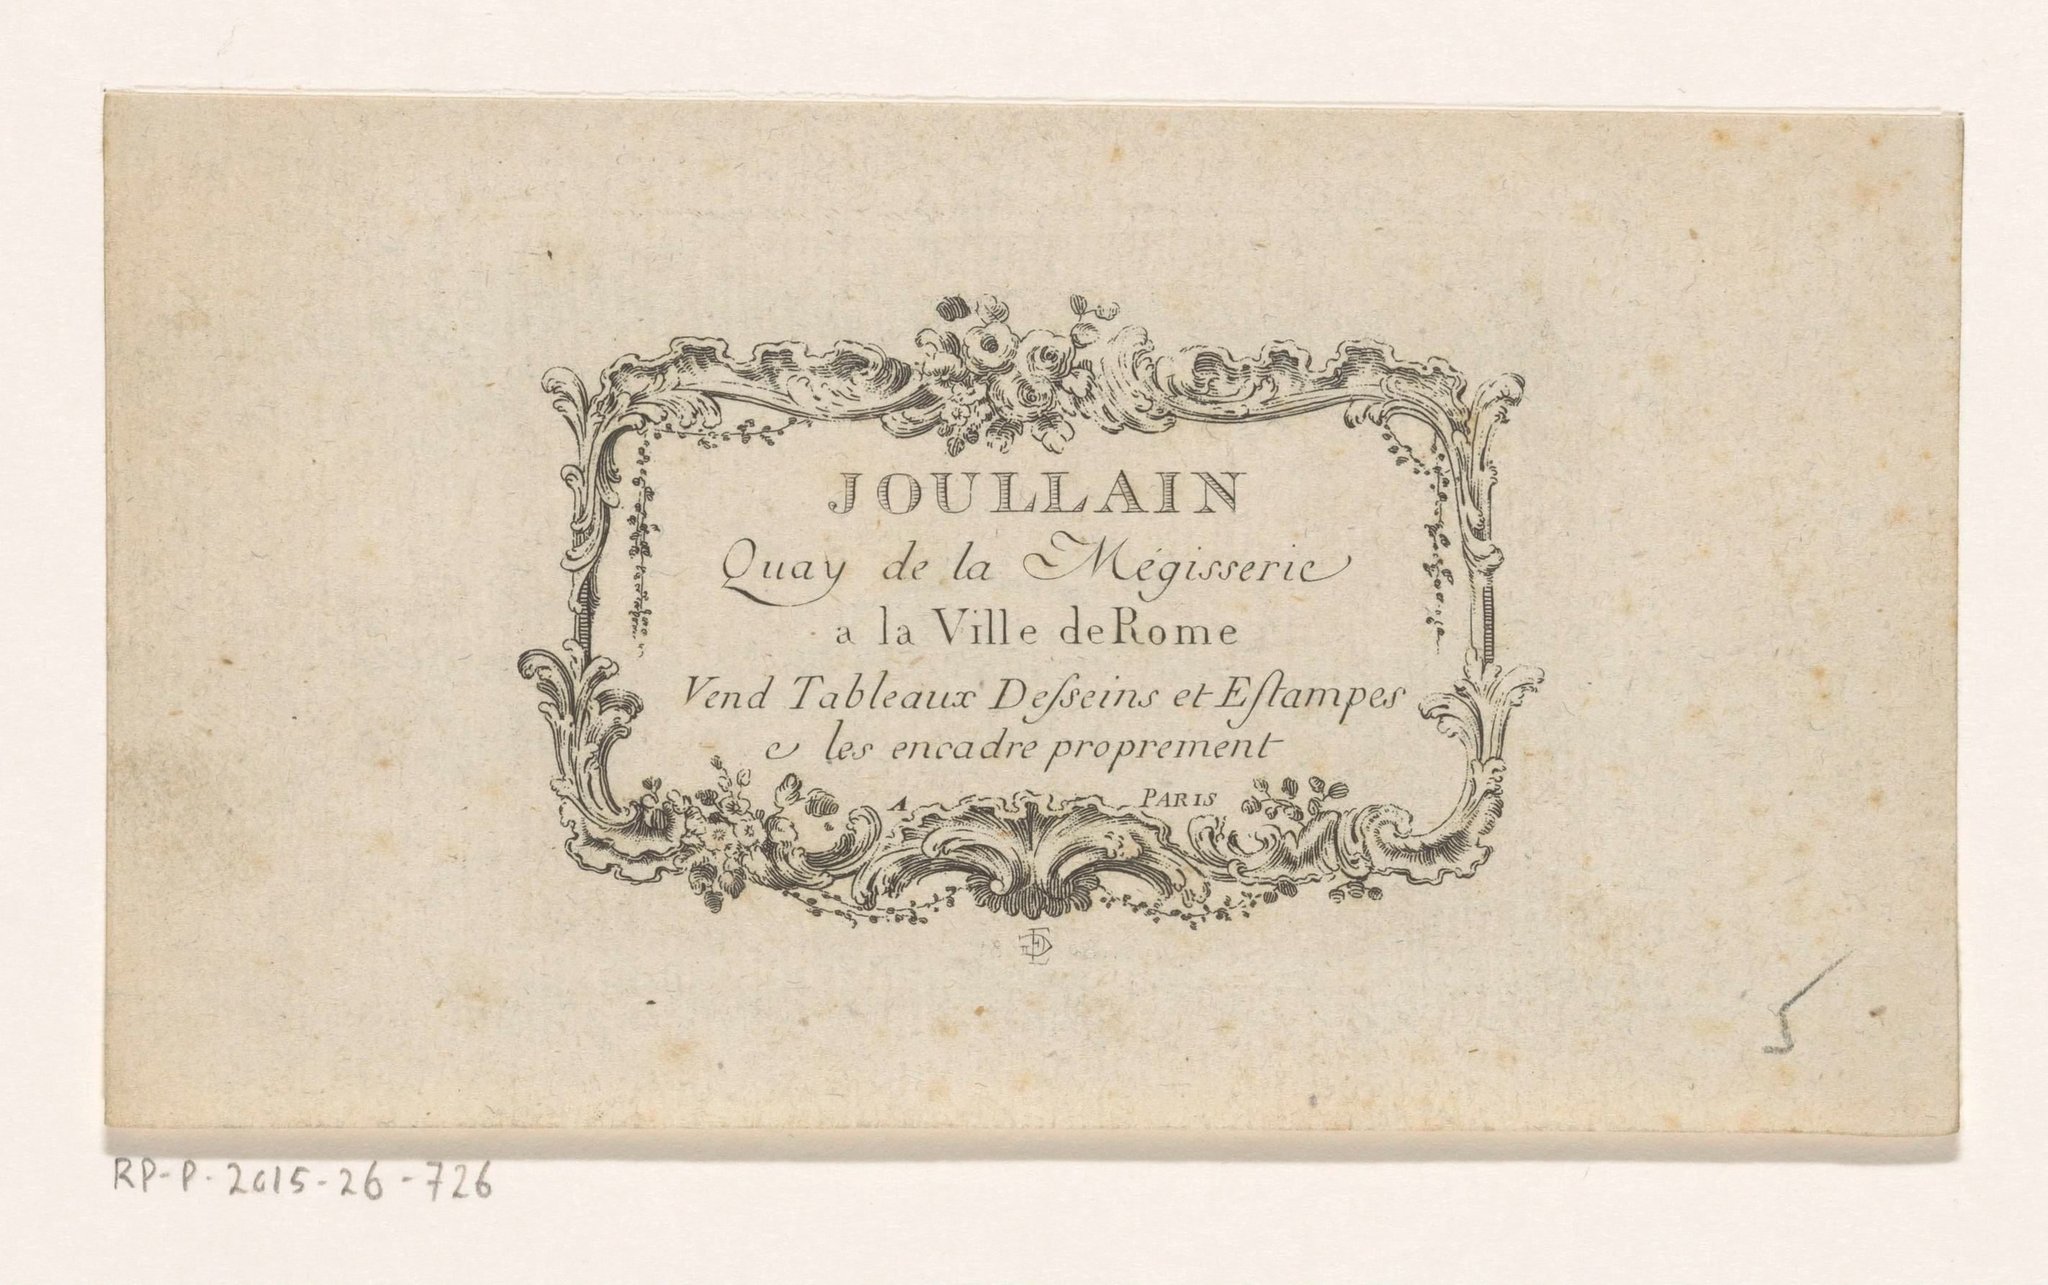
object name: print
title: Visitekaartje van kunsthandel Joullain te Parijs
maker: Anonymous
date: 1808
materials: paper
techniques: etching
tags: bunch of flowers ~ ornament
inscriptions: collector's mark: Lugt 2228